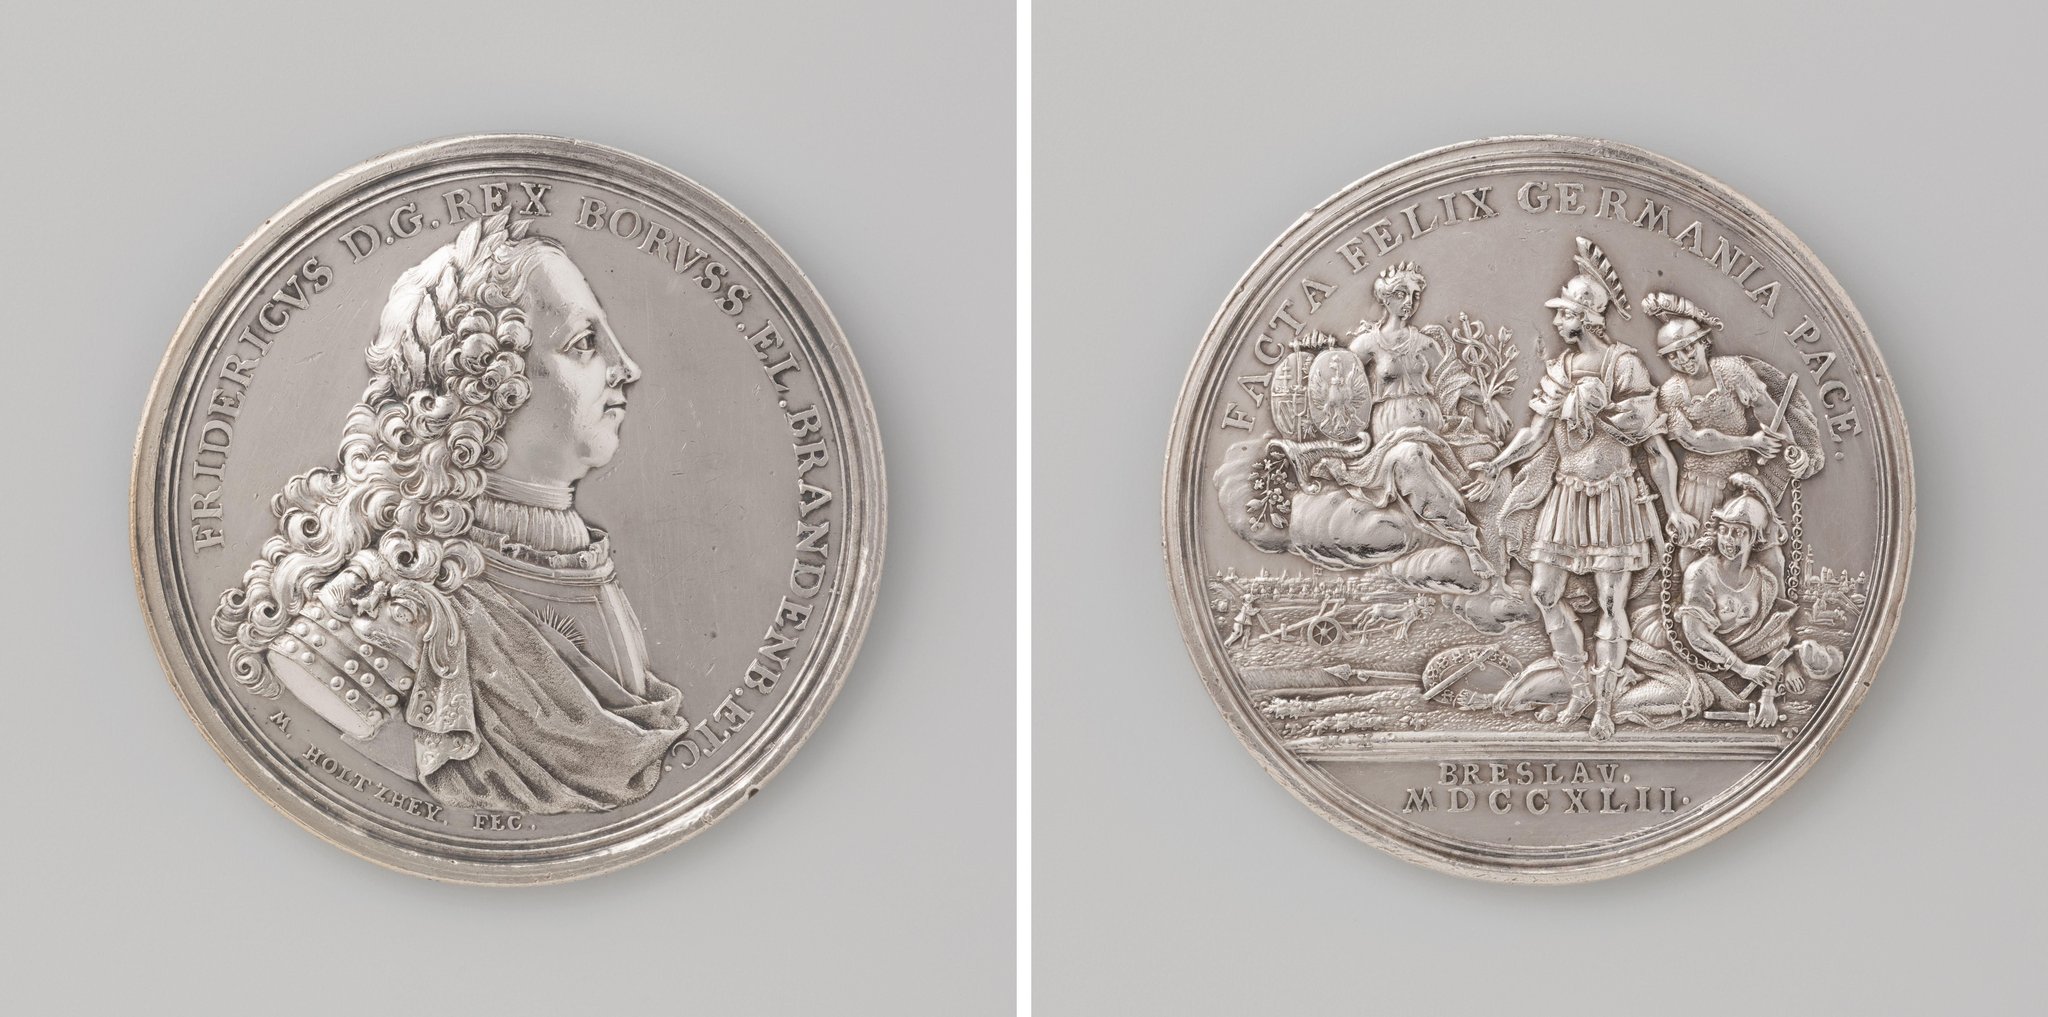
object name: history medal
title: Voorlopige vrede van Breslau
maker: martinus holtzhey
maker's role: medailleur, muntmaker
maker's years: 1697-1764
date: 1742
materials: silver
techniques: striking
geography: amsterdam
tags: karel alexander hertog van lotharingen, vienna, maria theresia (rooms-duits keizerin), berlin, frederick ii (king of prussia)